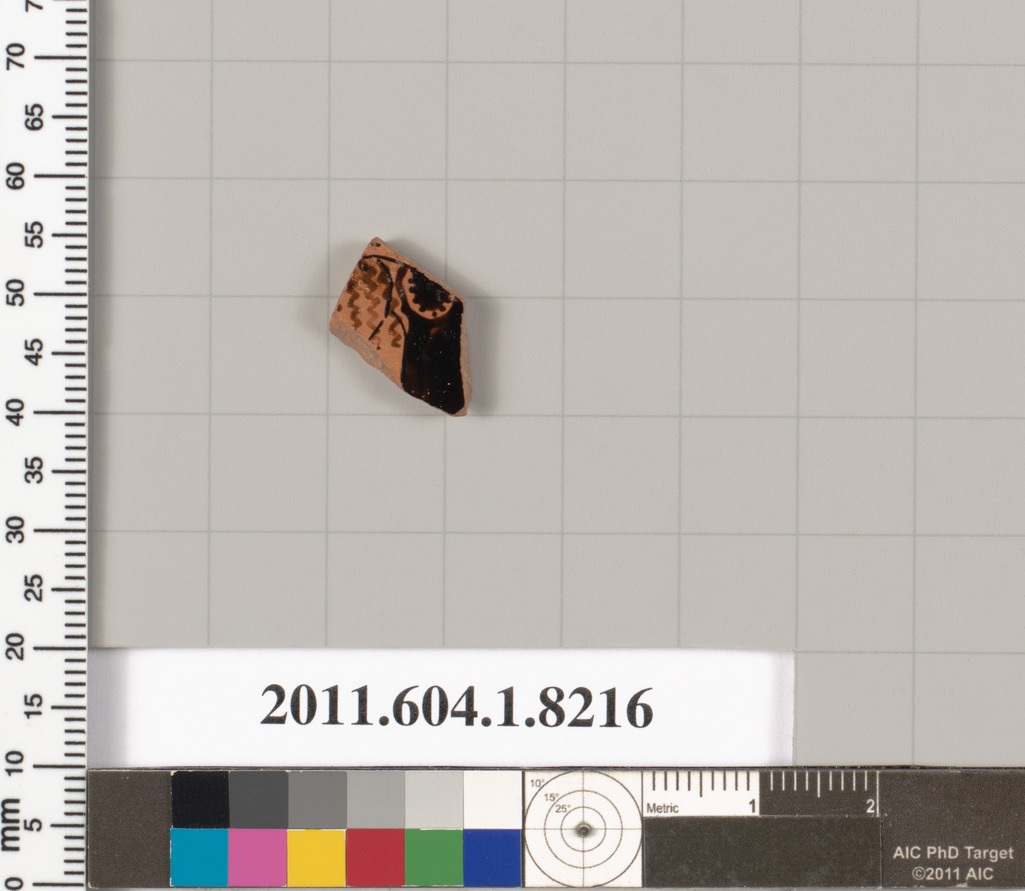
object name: kylix fragment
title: Terracotta fragment of a kylix (drinking cup)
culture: greek, attic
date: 520-510 BCE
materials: terracotta